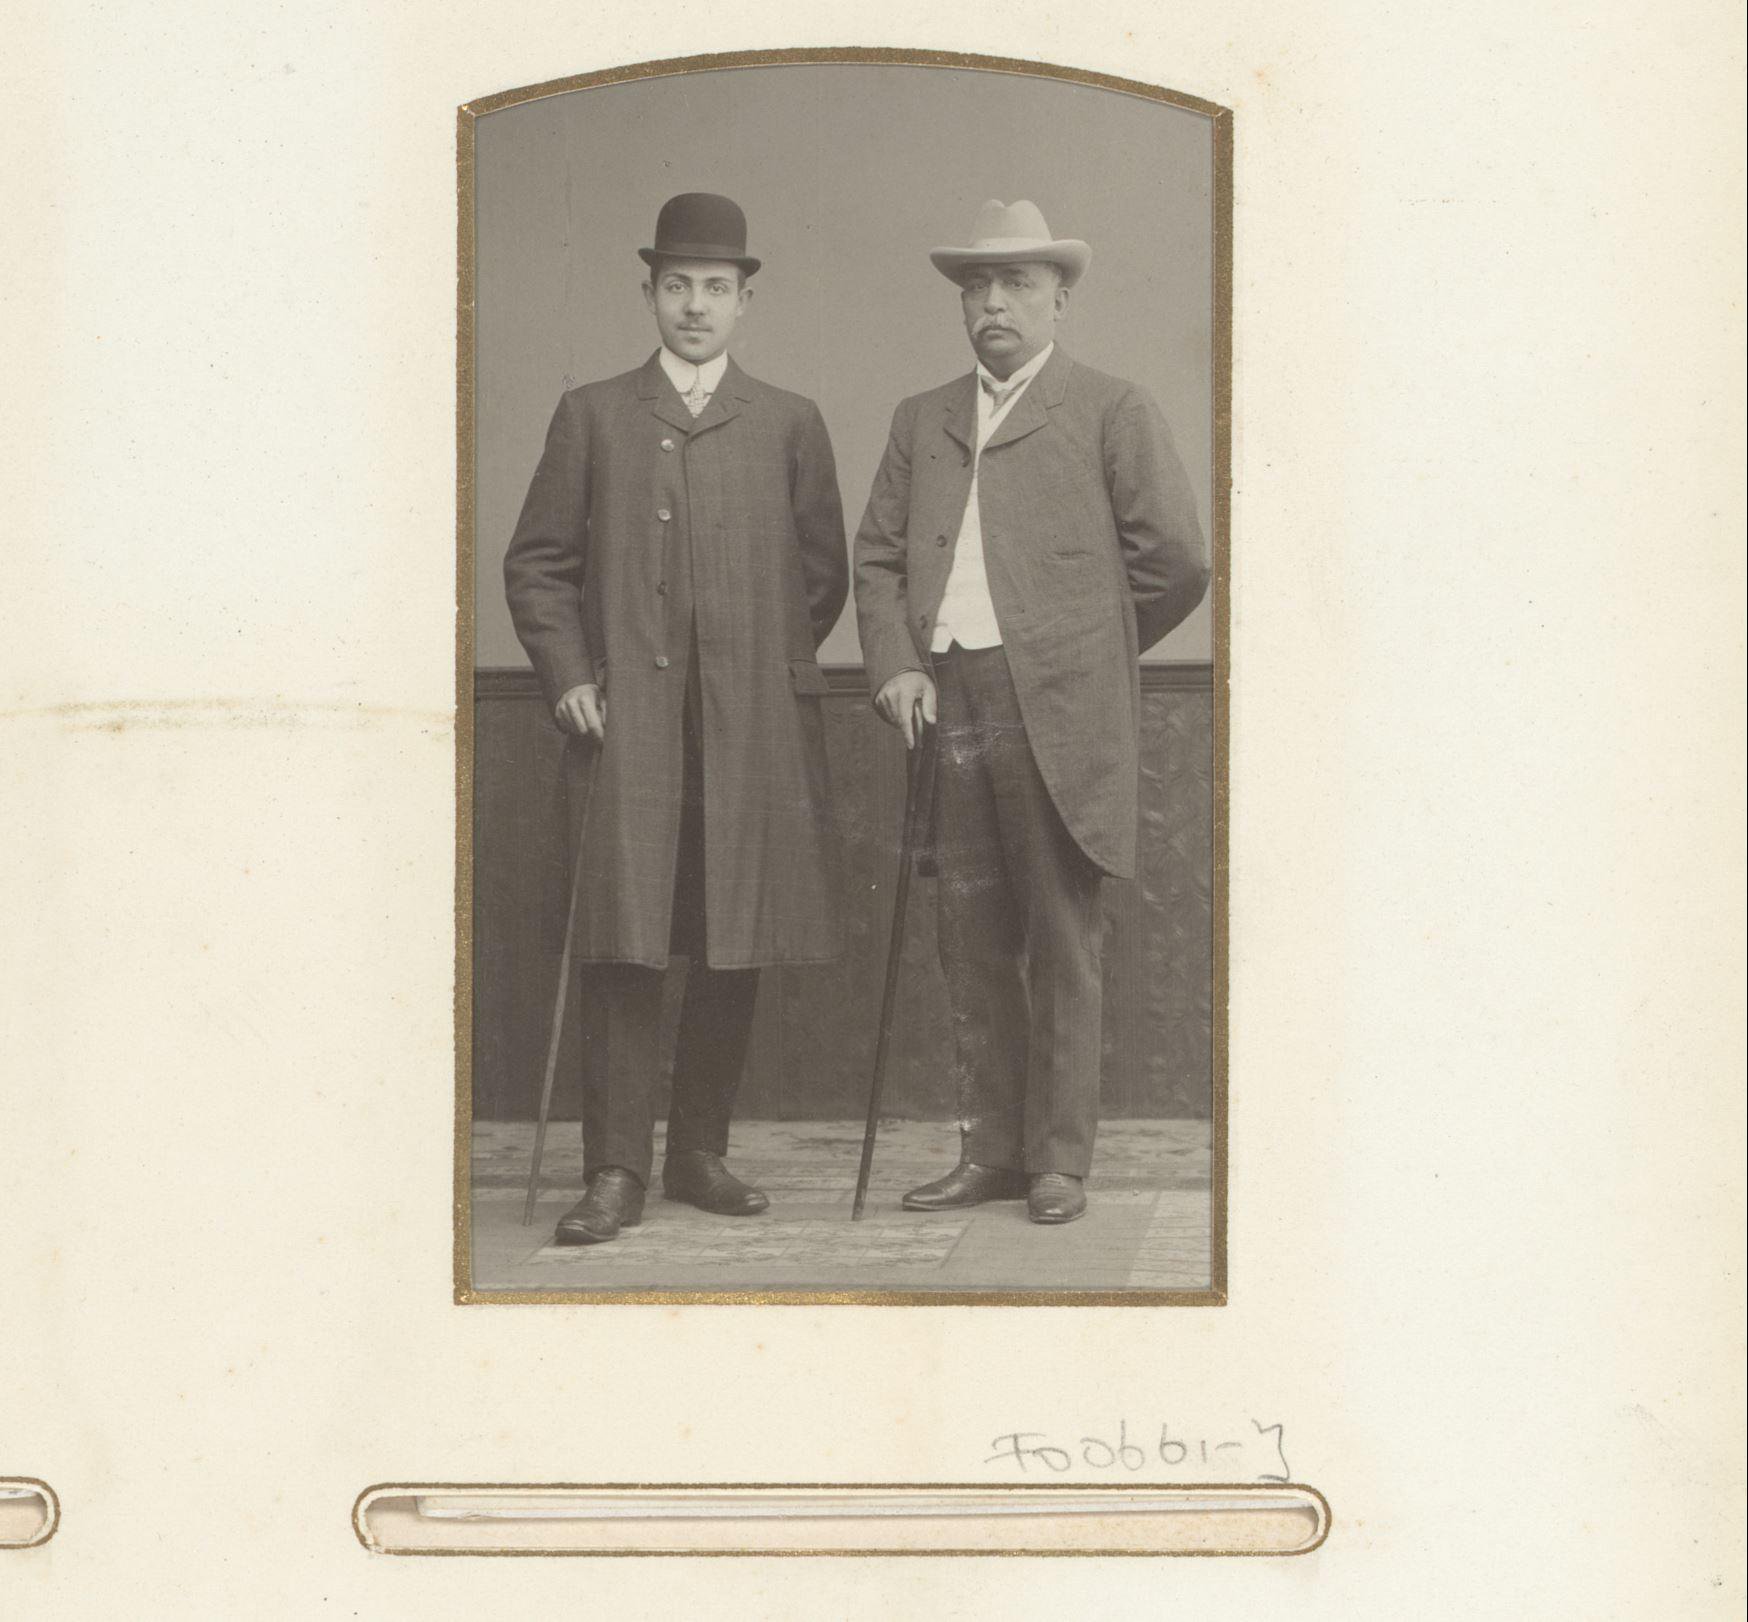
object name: photograph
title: Portret van twee staande mannen met hoed en wandelstok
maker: stephanus adrianus schotel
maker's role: fotograaf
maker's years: 1871-1957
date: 1902-1920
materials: cardboard, photographic support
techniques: matte daylight collodion silver print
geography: arnhem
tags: adult man (+ two persons), walking-stick, staff, historical persons, head-gear: hat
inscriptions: inscription: ‘S.A. Schotel/ Arnhem/ Velperbuitensingel 10.’, annotation: ‘*’